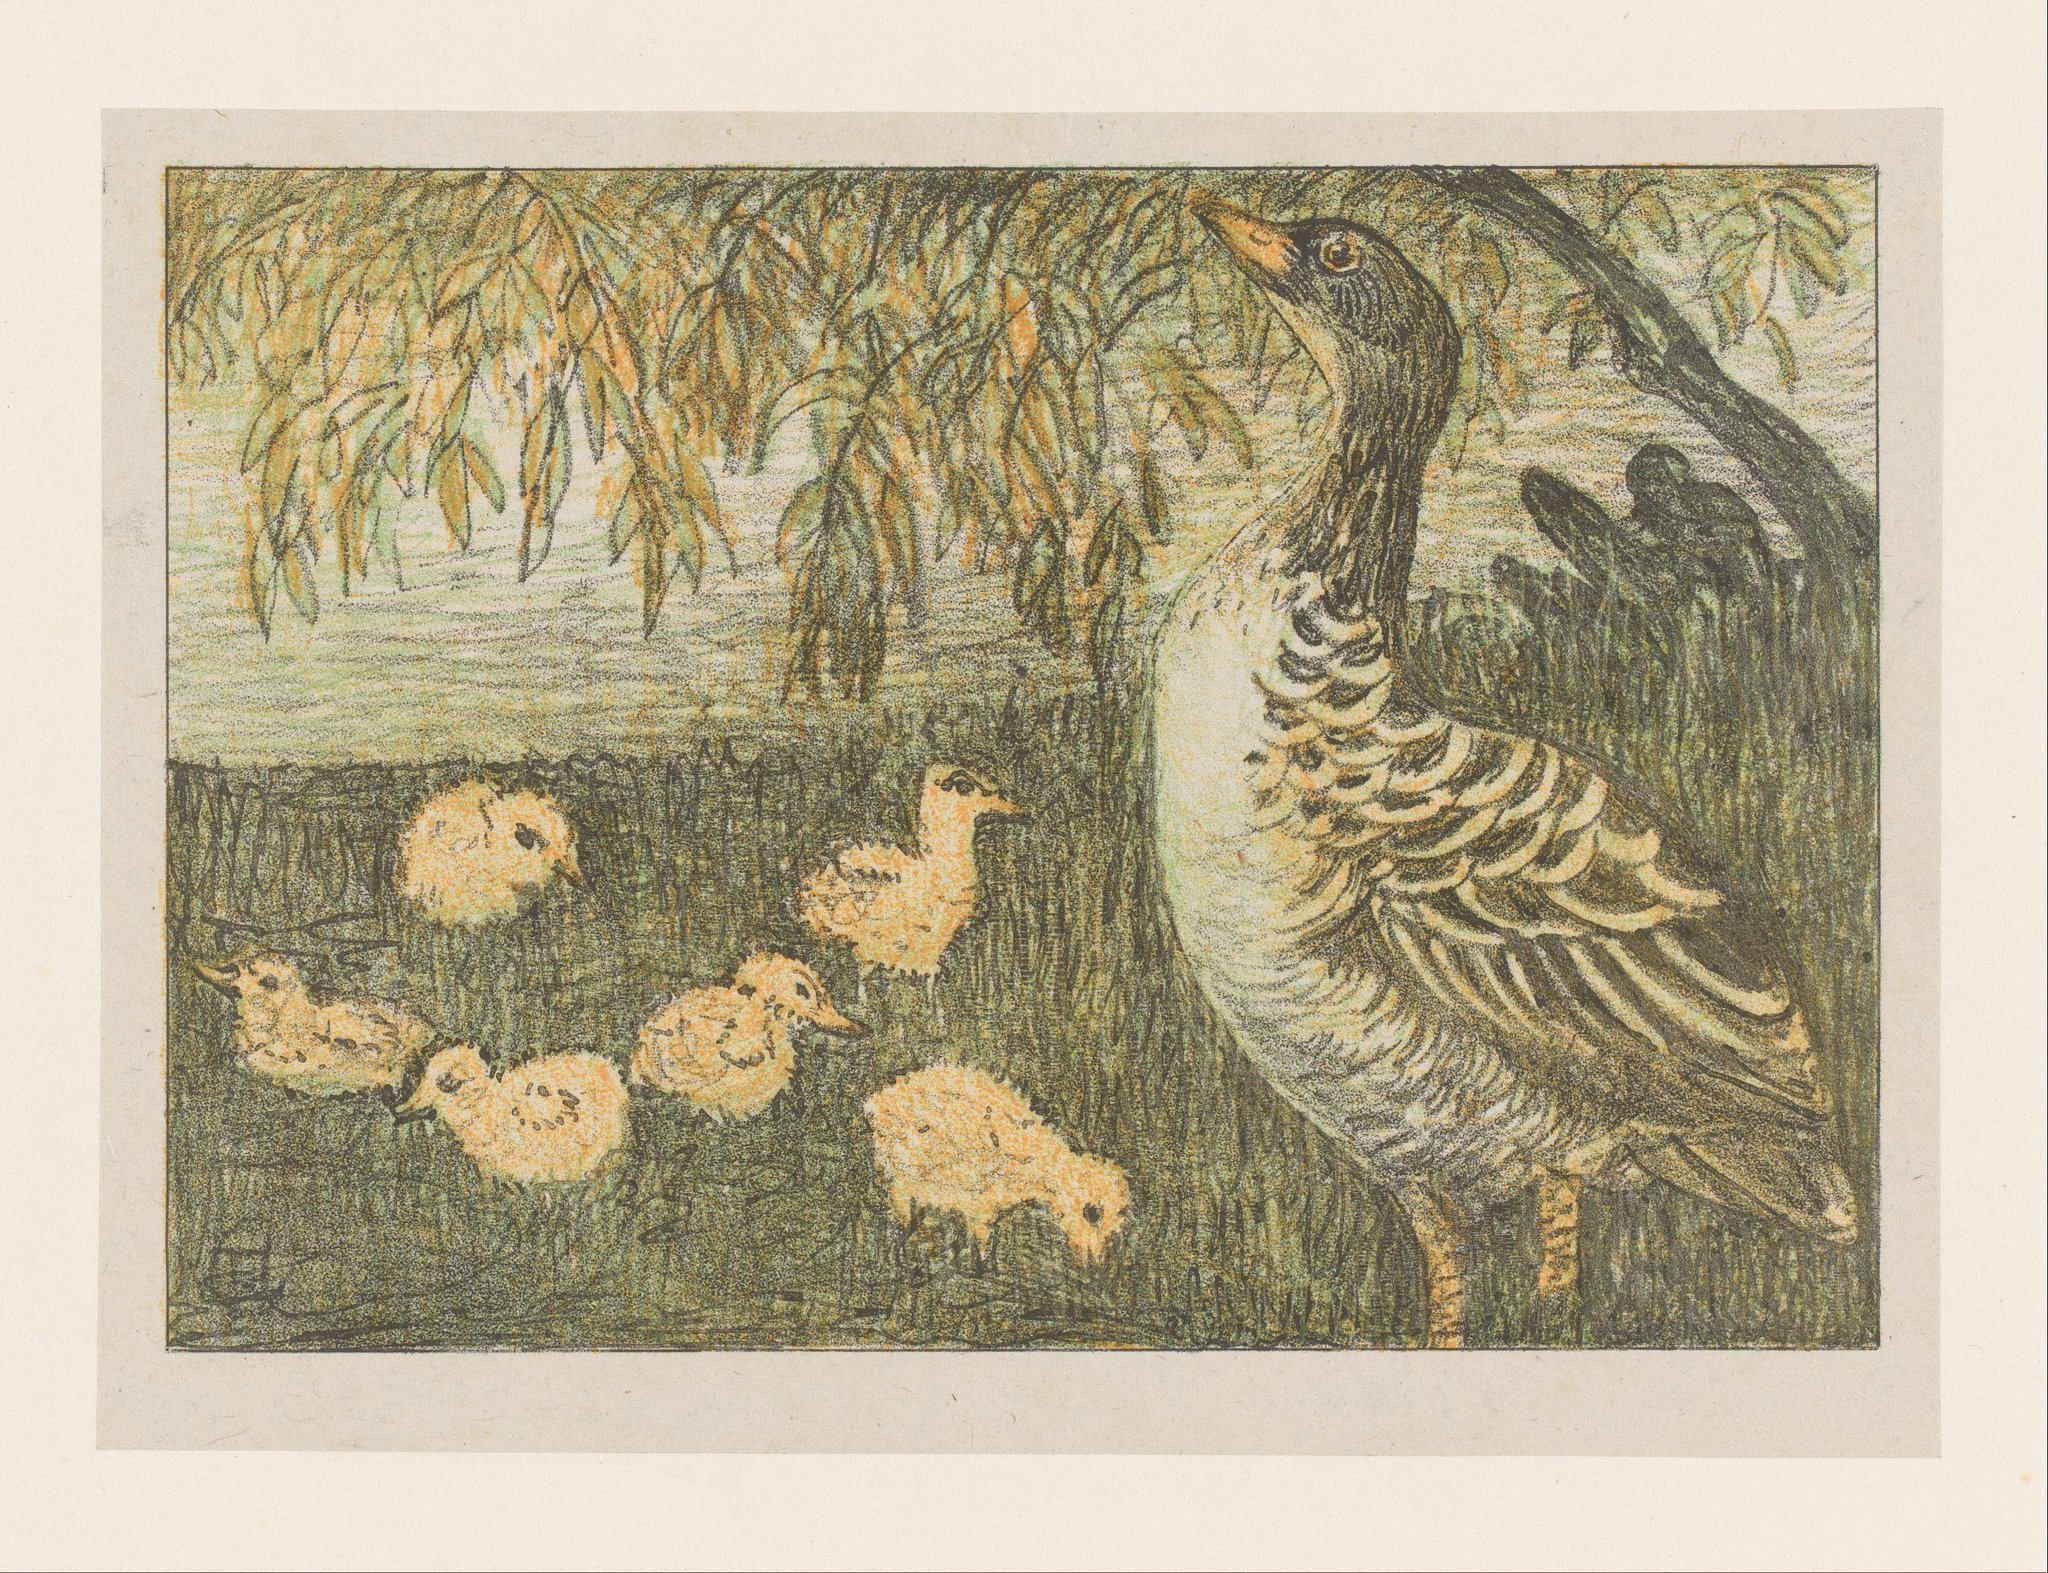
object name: print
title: Gans met kuikens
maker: theo van hoytema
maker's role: draughtsman, painter, print maker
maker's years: 1863-1917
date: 1878-1913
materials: paper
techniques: lithograph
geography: texel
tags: water-birds: goose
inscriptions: collector's mark: Lugt 2228, collector's mark: Lugt 4731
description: Prent is een proefdruk voor kalenderblad mei 1913.